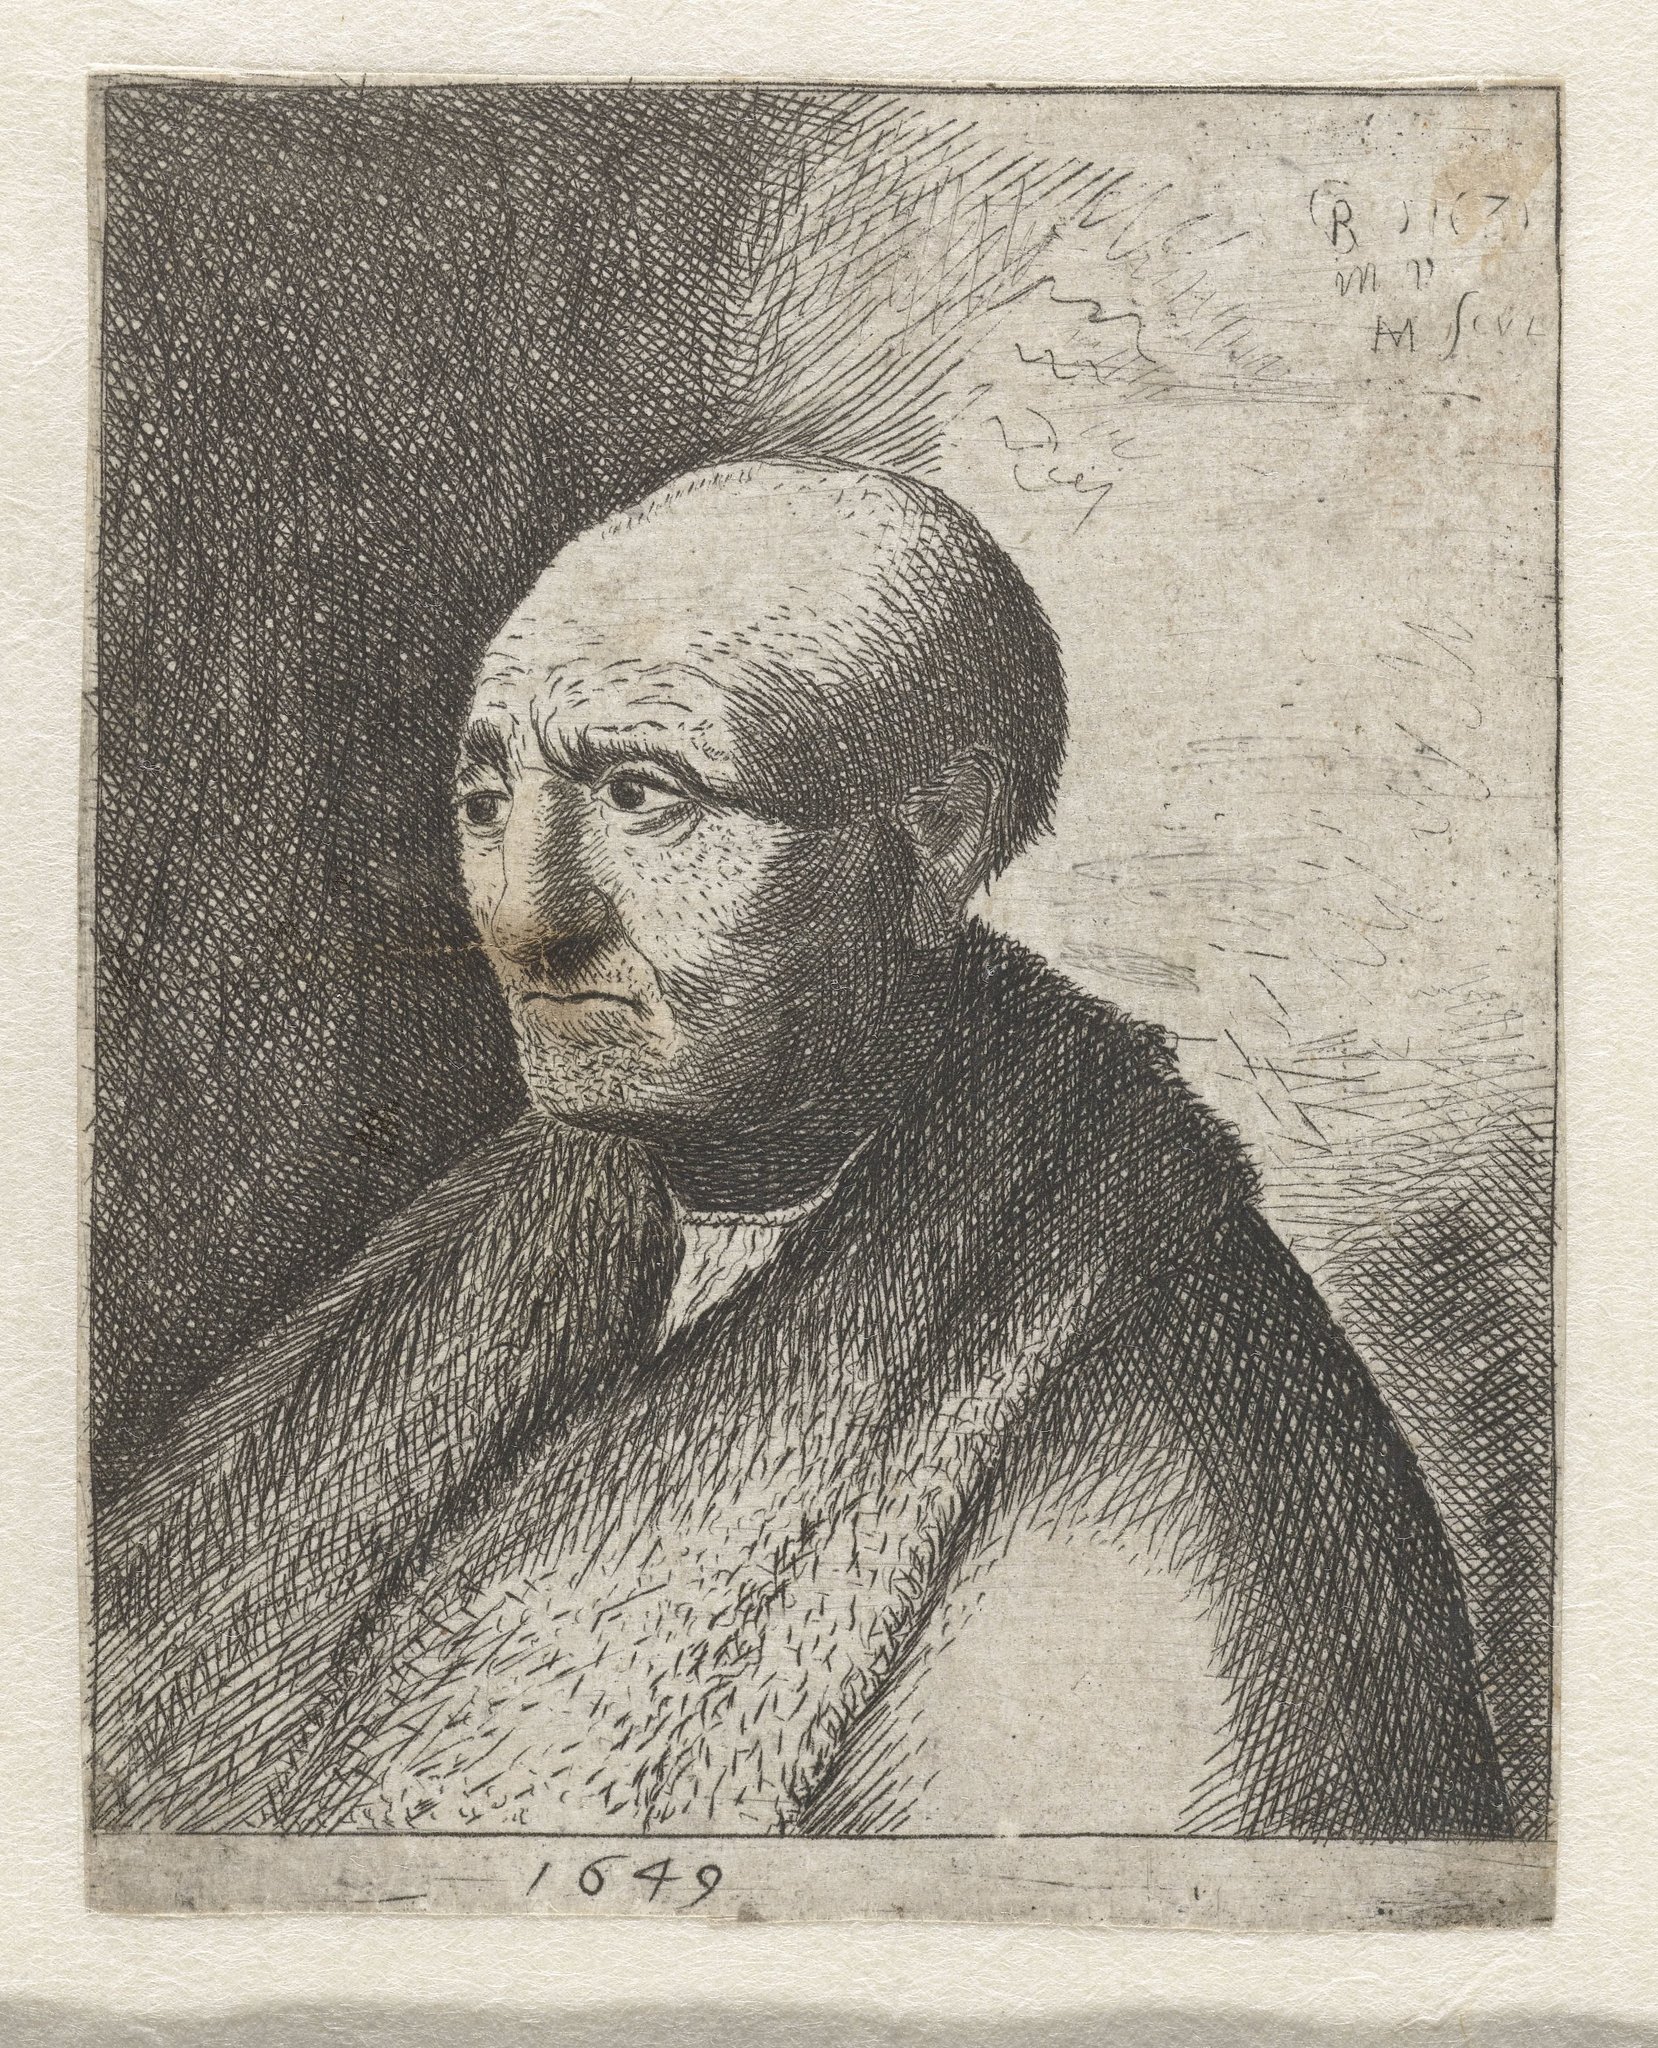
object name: print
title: Bald man in a fur cloak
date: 1649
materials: paper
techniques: etching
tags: adult man, baldness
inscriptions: collector's mark: Lugt 240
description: Spiegelbeeldige kopie naar de gelijknamige prent van Rembrandt.